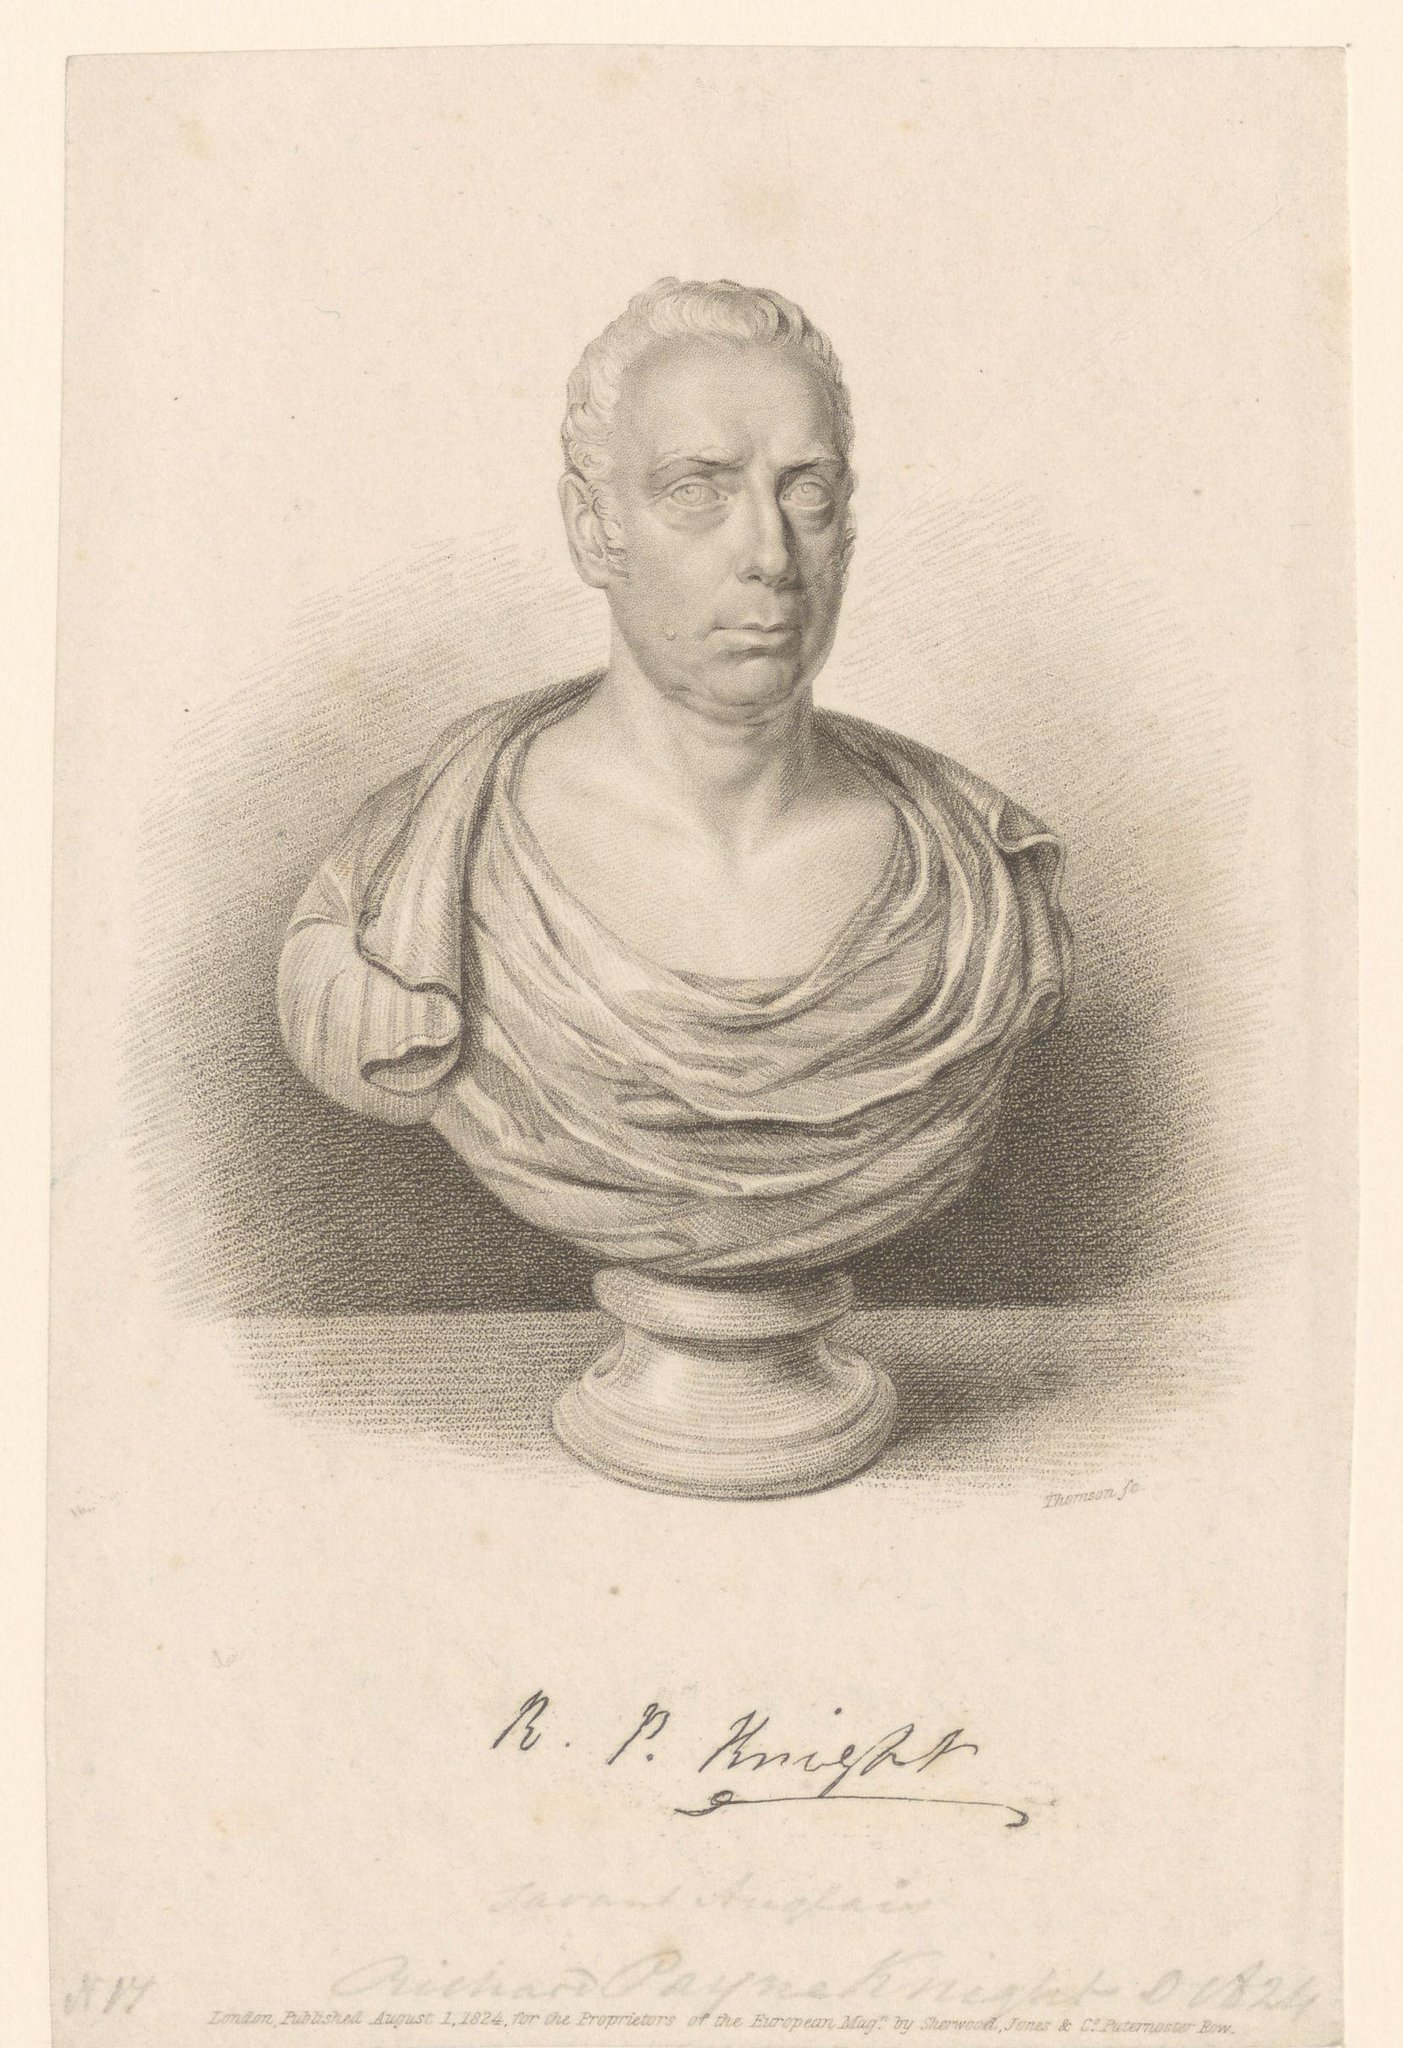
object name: print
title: Portretbuste van Richard Payne Knight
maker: james thomson (1789-1850)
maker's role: print maker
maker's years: 1789-1850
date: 1808-1824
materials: paper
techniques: roulette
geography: london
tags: history and archaeology (+ portrait of scholar, scientist), historical persons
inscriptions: collector's mark: Lugt 2228